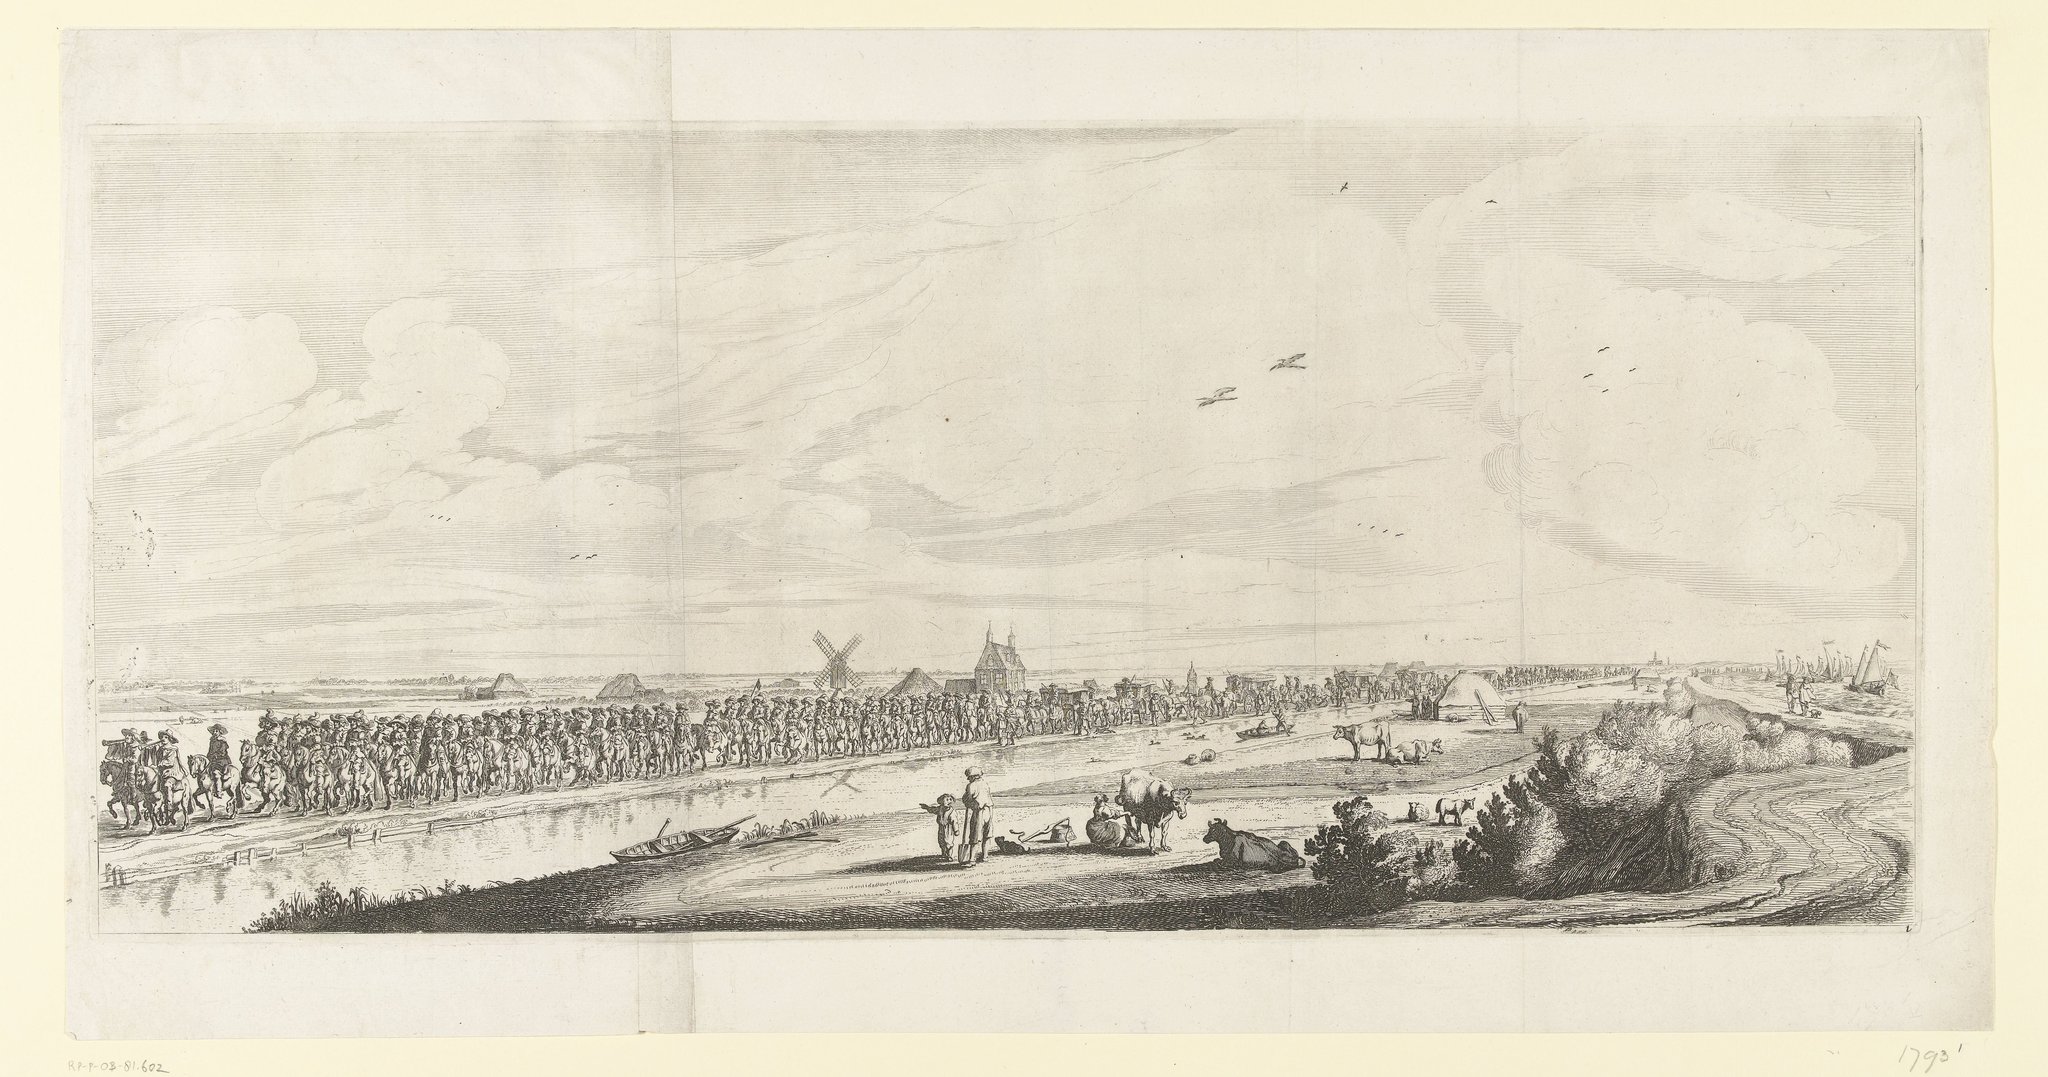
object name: print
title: Optocht van de stoet met Maria de Médicis langs de Haarlemmerweg (plaat nr. 1), 1638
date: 1638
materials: paper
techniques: etching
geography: northern netherlands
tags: cologne, maria de' medici, triumphal entry and public reception, pageant, 'entrée solennelle', 'joyeuse entrée'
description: Optocht van de stoet met Maria de Médicis langs de Haarlemmerweg. De rijtuigen van de koningin begeleid door de Amsterdamse schutterij. Rechts bootjes op het IJ. Plaat nr. 1 in de illustraties in de beschrijving van de feestelijkheden bij het bezoek van Maria de Médicis aan Amsterdam, 31 augustus - 5 september 1638.